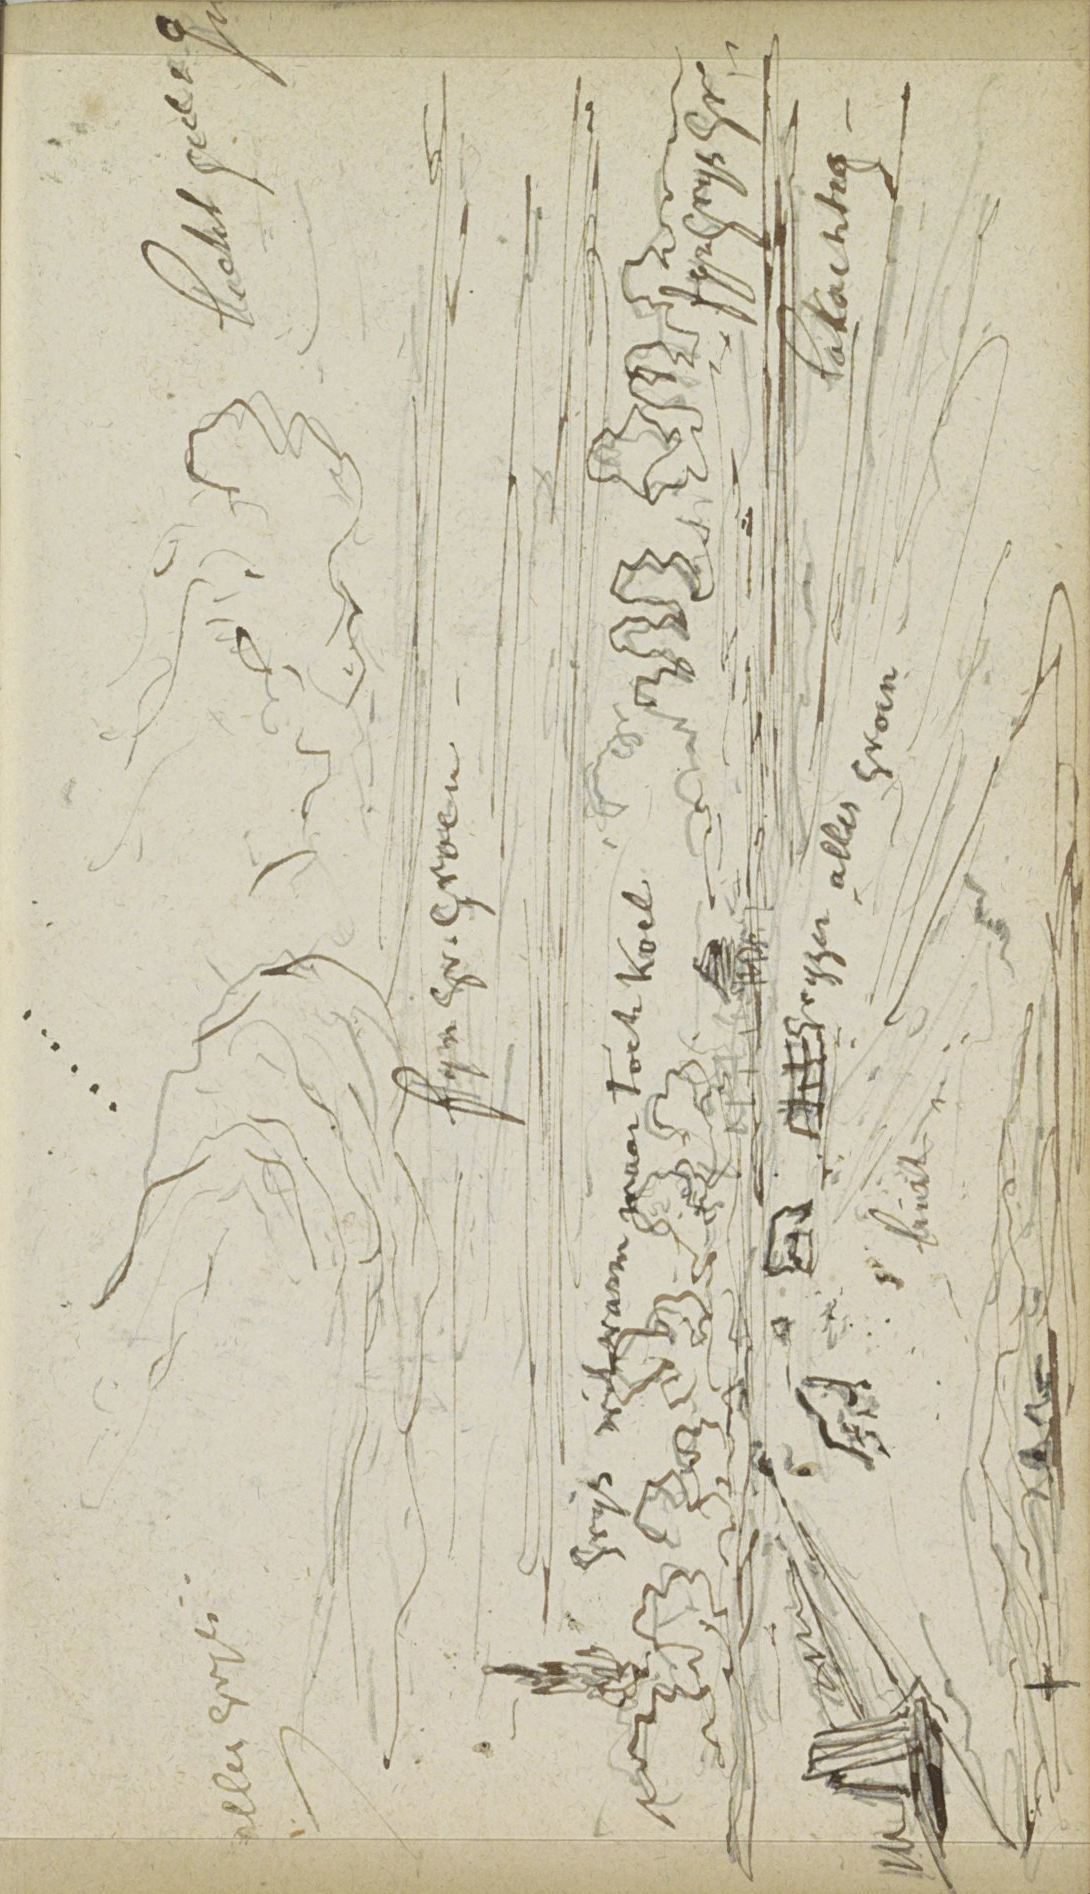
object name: sketchbook leaf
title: Weiland met grazend vee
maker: johannes tavenraat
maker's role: draughtsman, painter, print maker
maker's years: 1809-1881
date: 1854-1868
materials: ink, paper, pencil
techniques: pen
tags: cattle, meadow, pasture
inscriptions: kleurnotitie, handgeschreven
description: Blad 61 recto uit een schetsboek met 88 bladen.